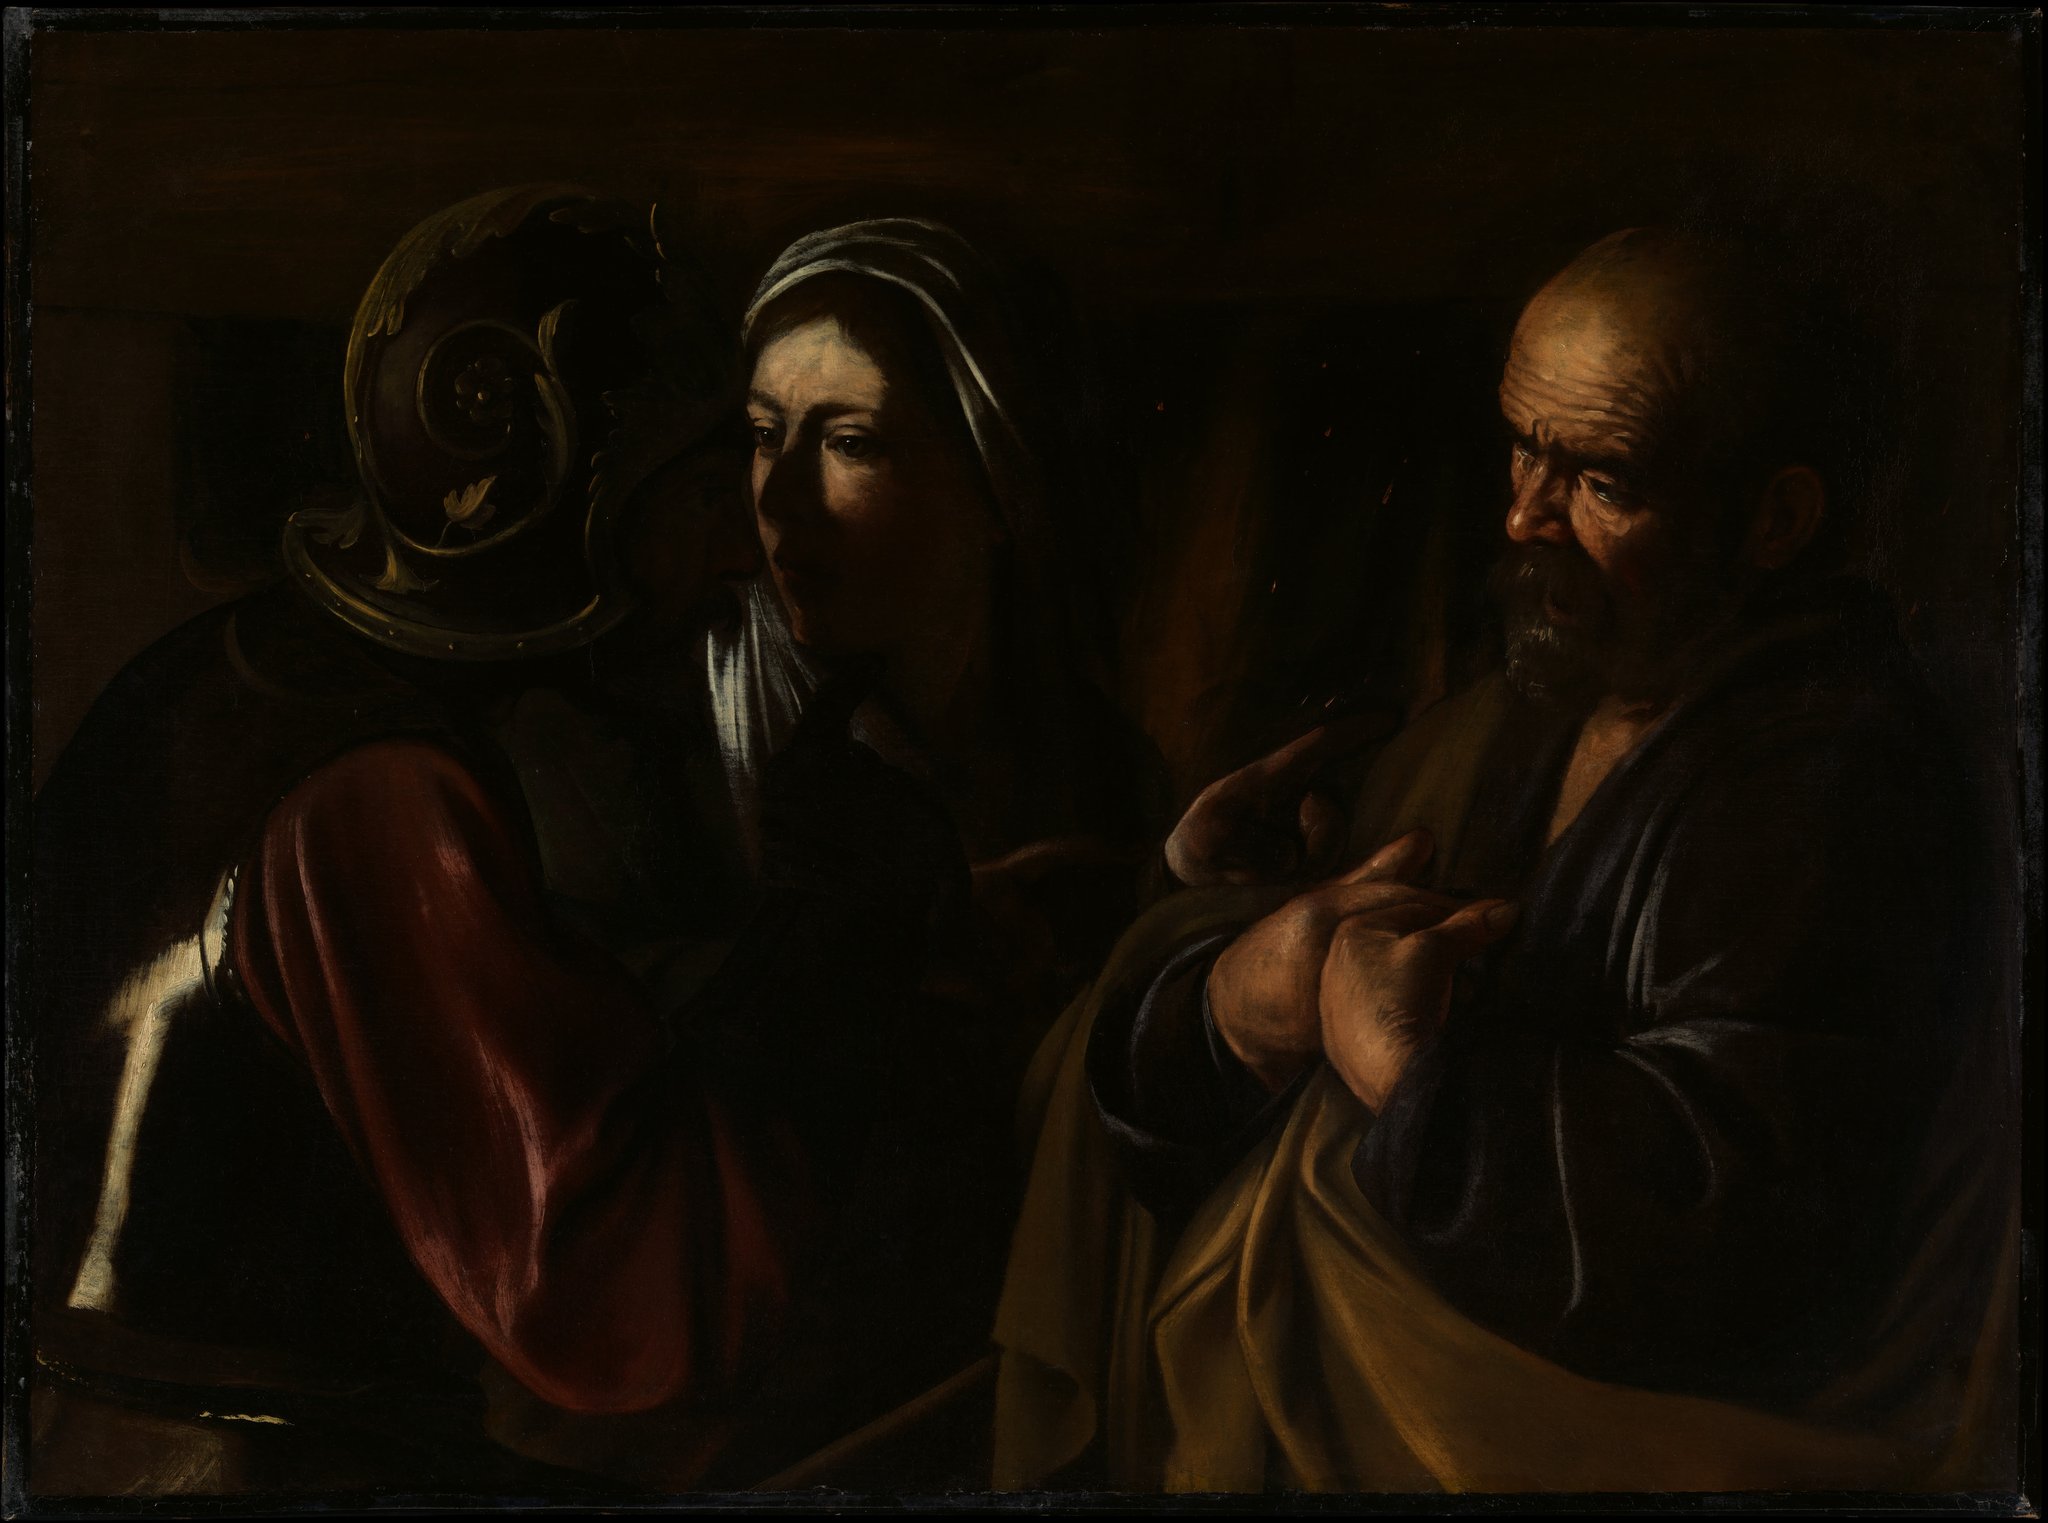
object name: painting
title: The Denial of Saint Peter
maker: caravaggio (michelangelo merisi)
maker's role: artist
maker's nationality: italian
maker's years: 1571-1610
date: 1610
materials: canvas, oil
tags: soldiers,men,women,saint peter